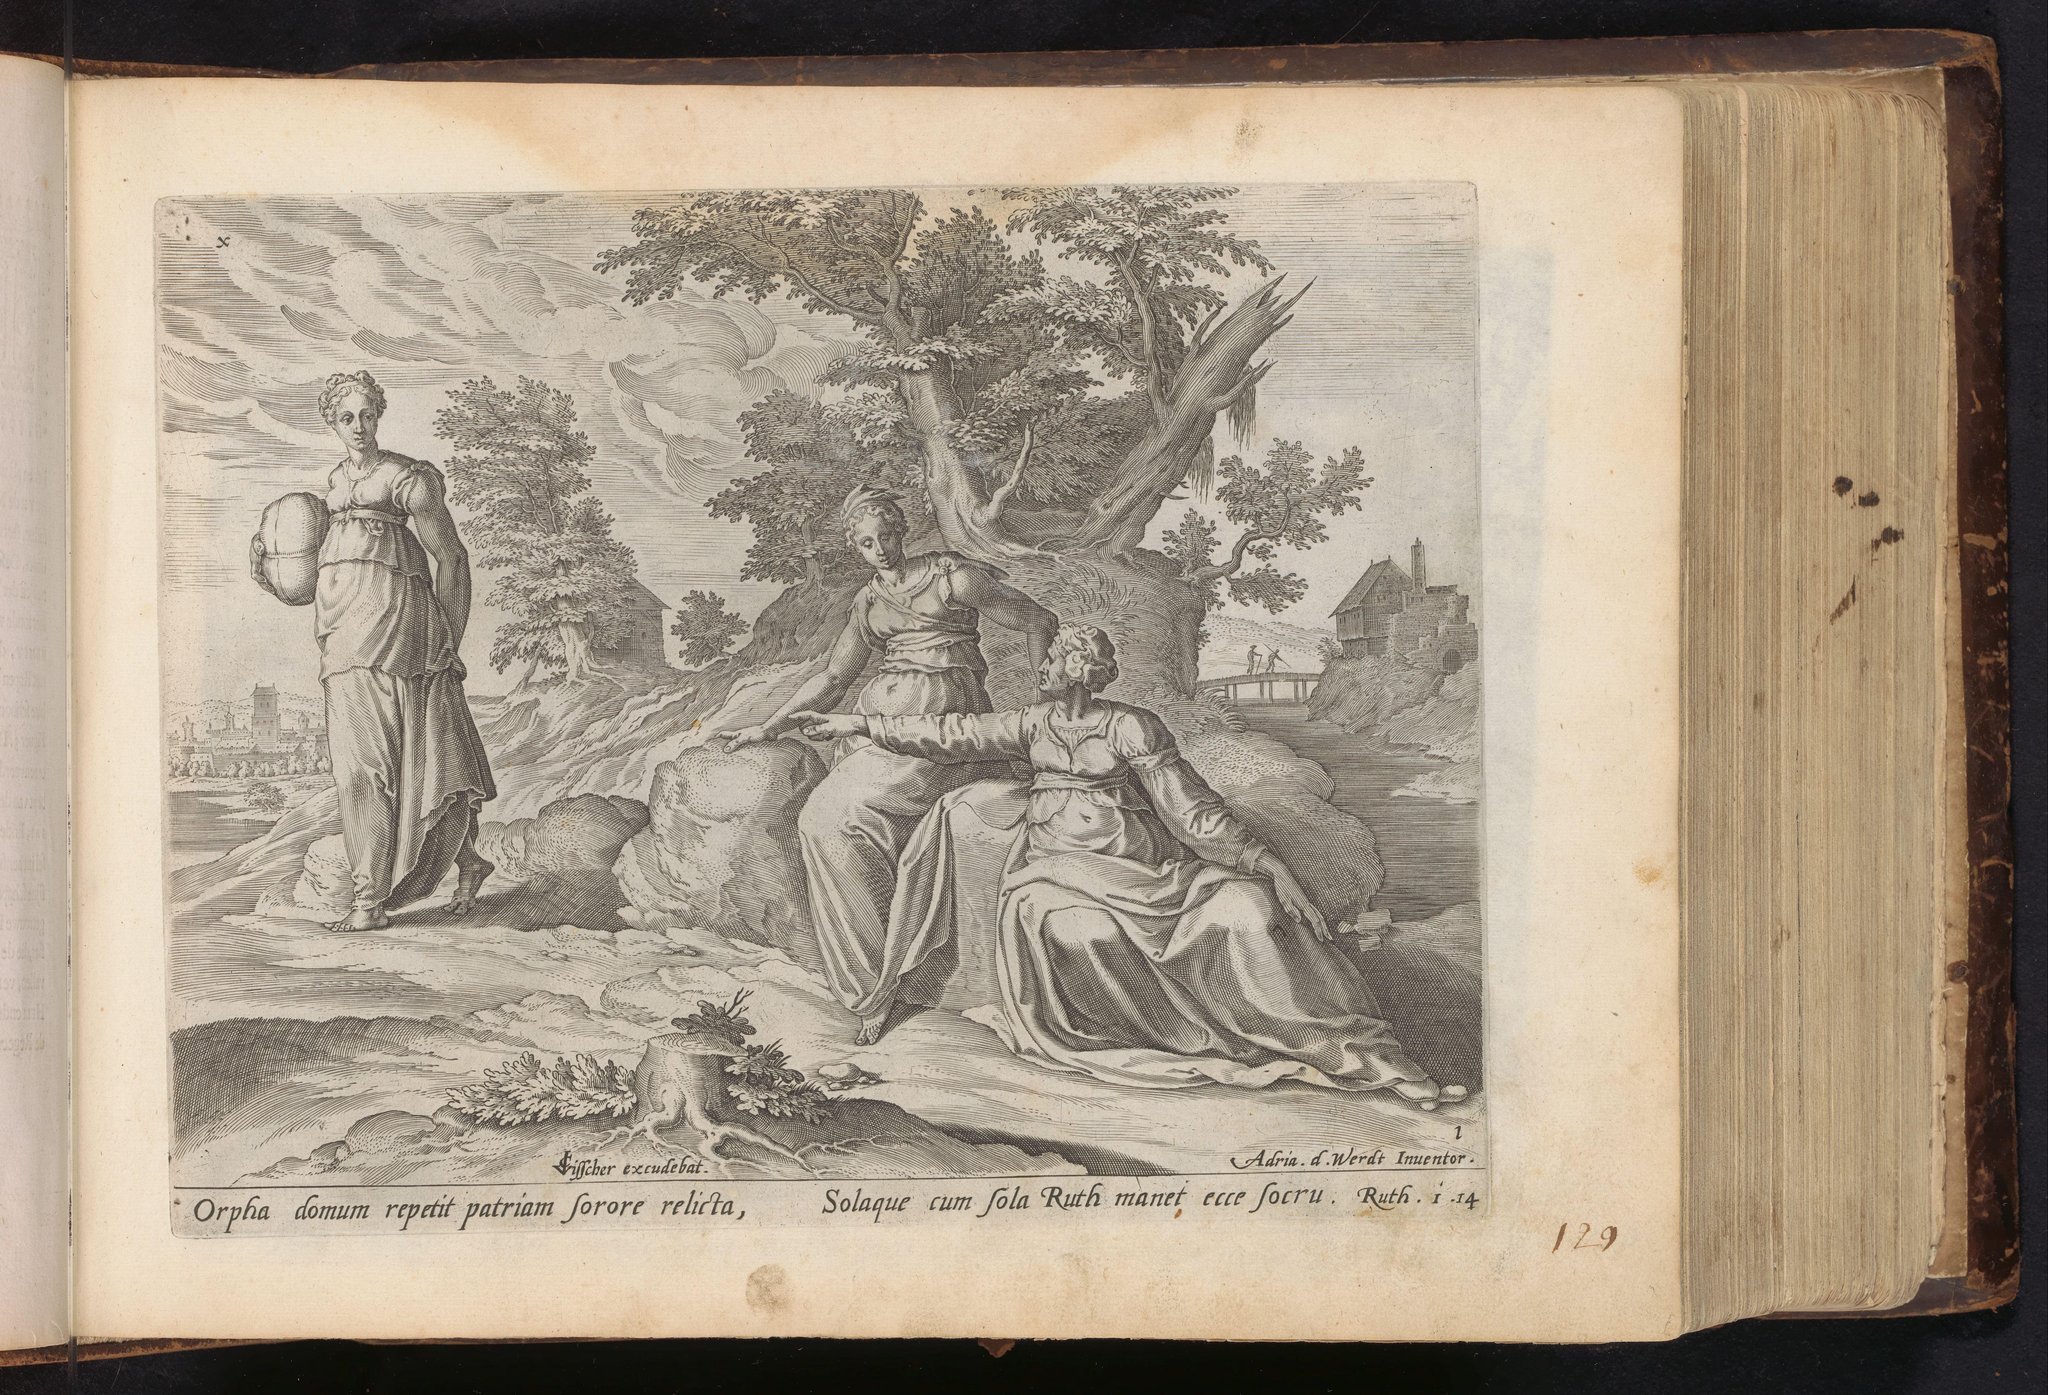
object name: print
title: Orpa verlaat Ruth en Naomi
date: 1579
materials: paper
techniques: engraving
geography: amsterdam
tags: naomi sends away her daughters-in-law: orpah returns home, ruth stays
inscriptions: number: ‘129’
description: Naomi reist met haar twee schoondochters naar Juda. Onderweg stuurt ze de vrouwen terug naar hun ouderlijk huis. Orpa vertrekt, maar Ruth blijft bij Naomi. Ruth en Naomi zitten op stenen aan de oever van een rivier. Orpa vertrekt met haar bagage onder de arm. Onder de voorstelling een verwijzing in het Latijn naar de Bijbeltekst in Ruth 1:14. Deze prent maakt deel uit van een album.